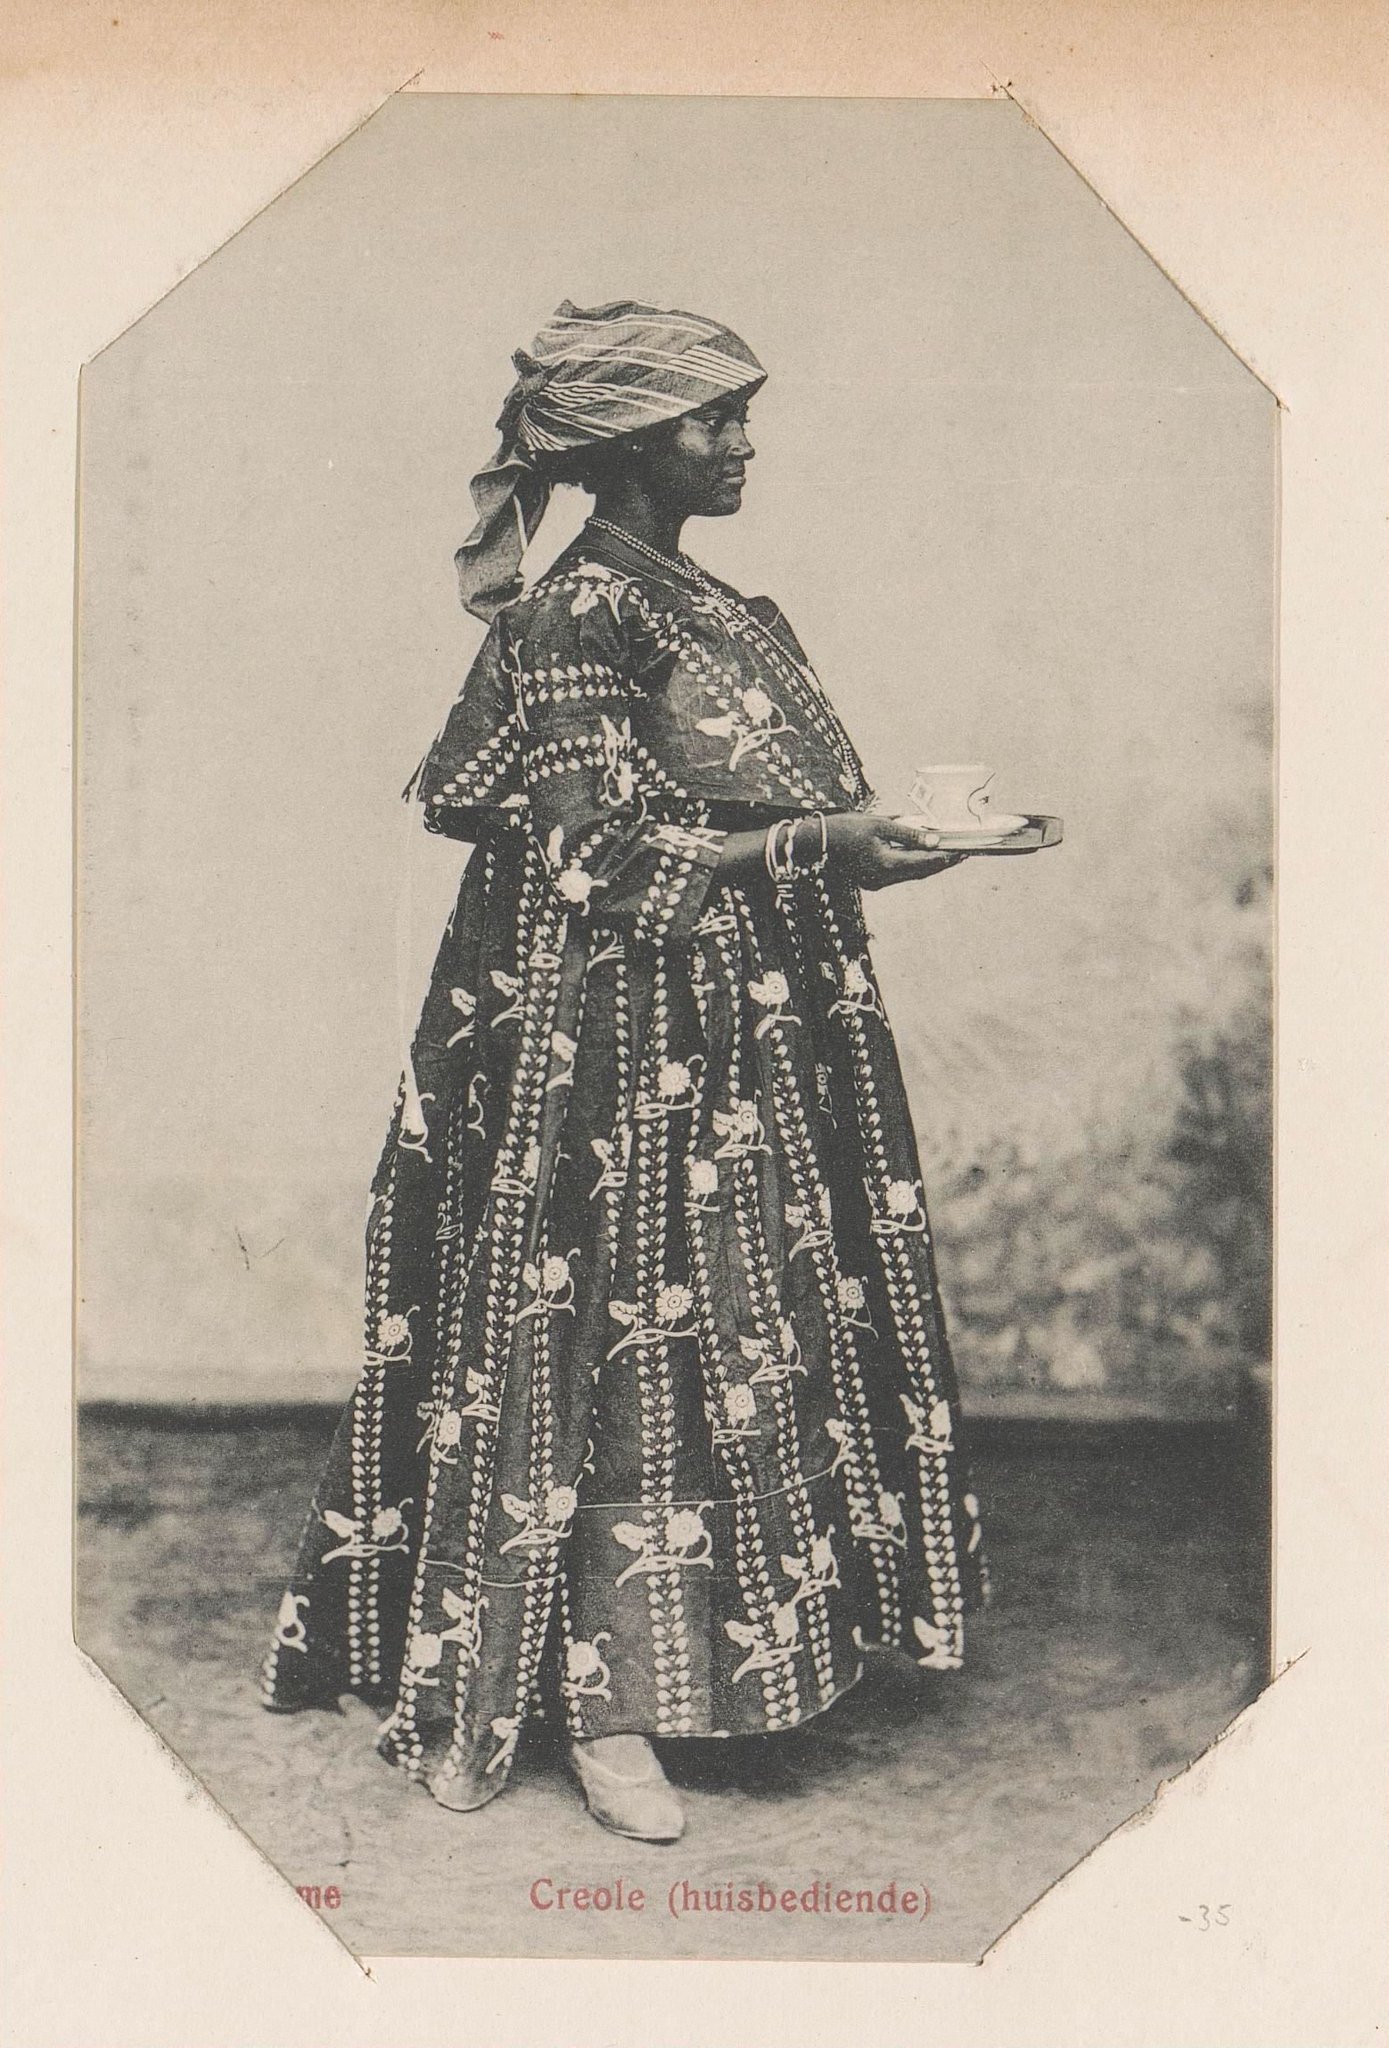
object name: ansichtkaart, prentbriefkaart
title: Staande vrouw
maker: eugen klein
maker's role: fotograaf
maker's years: 1869-1927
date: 1900-1910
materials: cardboard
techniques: photograph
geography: suriname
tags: folk costume, regional costume, standing figure - aa - female human figure, maid ~ house personnel, suriname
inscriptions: serial number: ‘Eigendom van Eugen Klein, Paramaribo No. 190’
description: Staande Surinaamse vrouw in koto. Huisbediende met een dienblad waarop een kop en schotel. Onderdeel van een verzameling van 68 briefkaarten uit Suriname, bijeengebracht in een album als aandenken aan een verblijf in Suriname in september 1911.